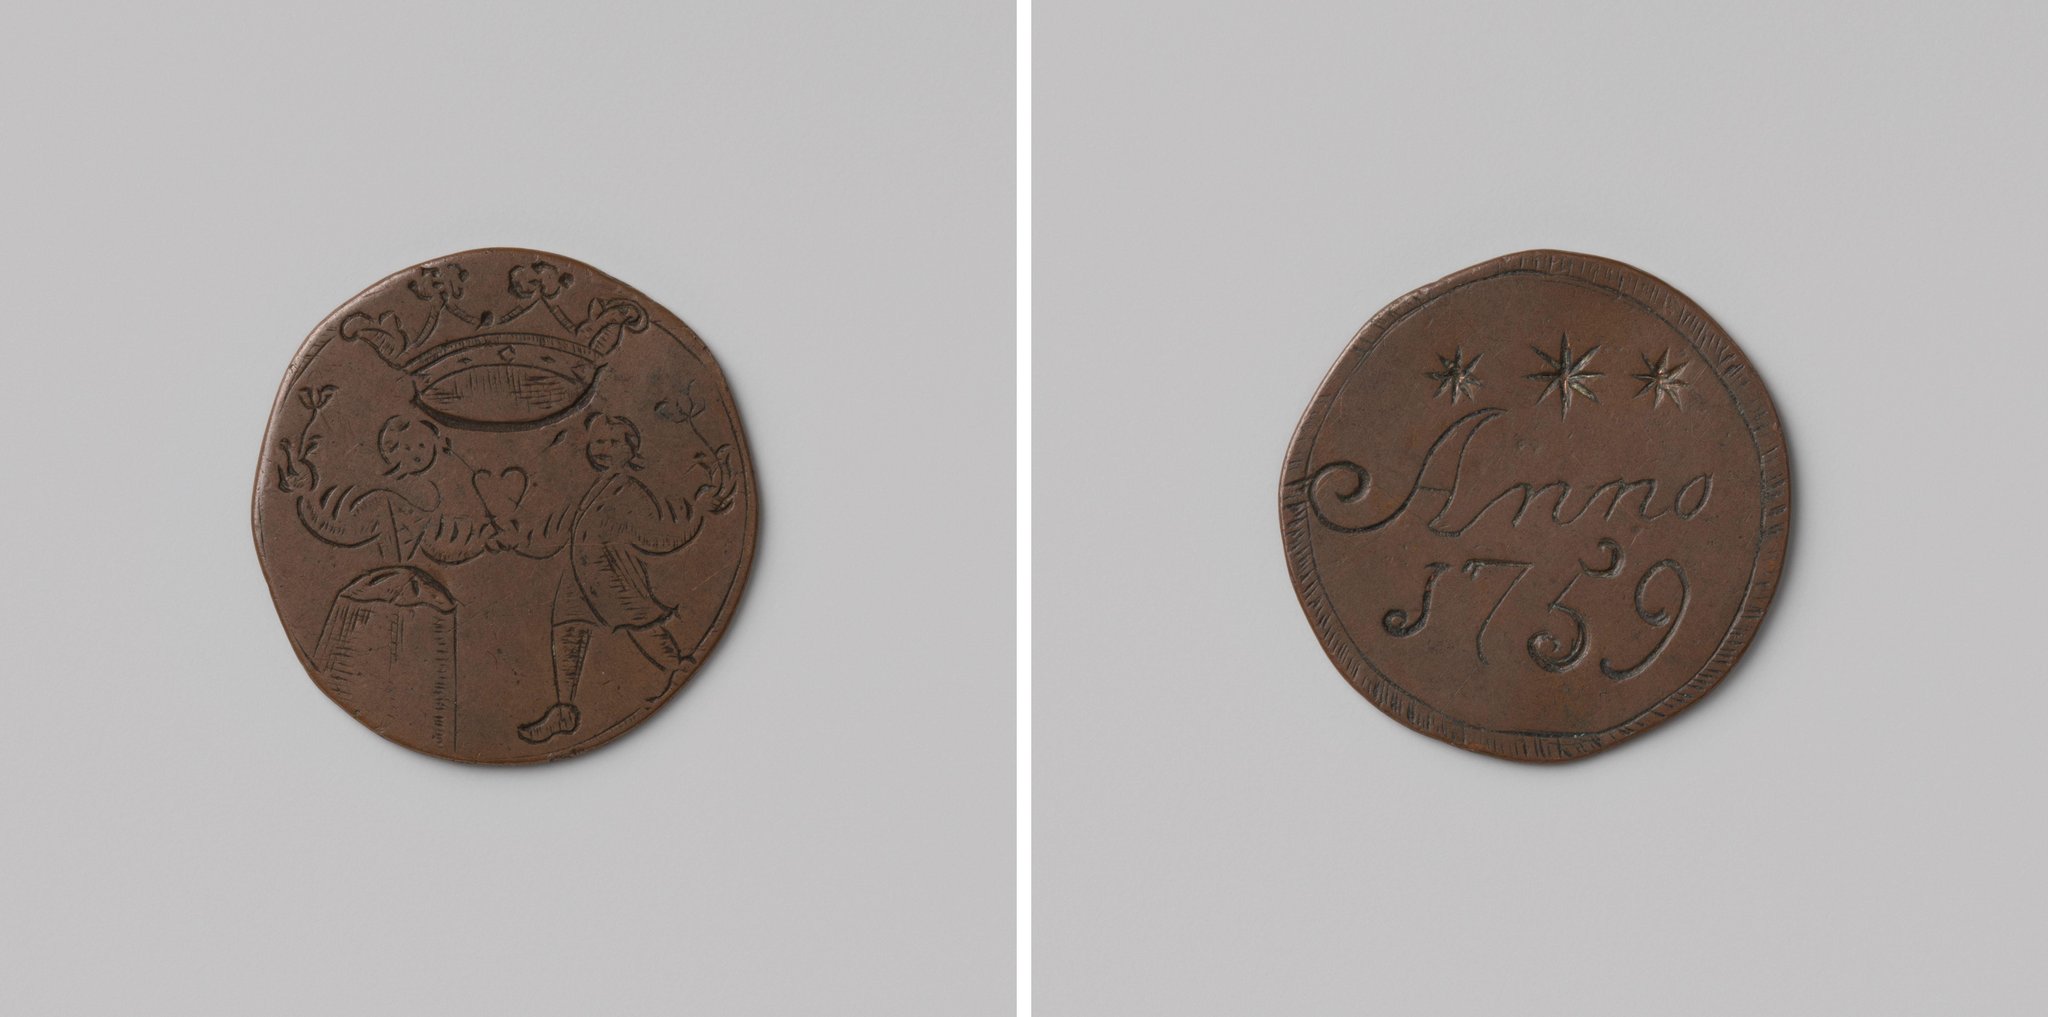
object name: medal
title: Verlovingspenning uit 1759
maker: Anonymous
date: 1759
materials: copper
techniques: engraving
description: Koperen penning. Voorzijde: onder een kroon houden man en vrouw, die in respectievelijk rechter- en linkerhand een bloem houden met hun andere hand gezamelijk een hart vast. Keerzijde: jaartal onder drie achtpuntige sterren